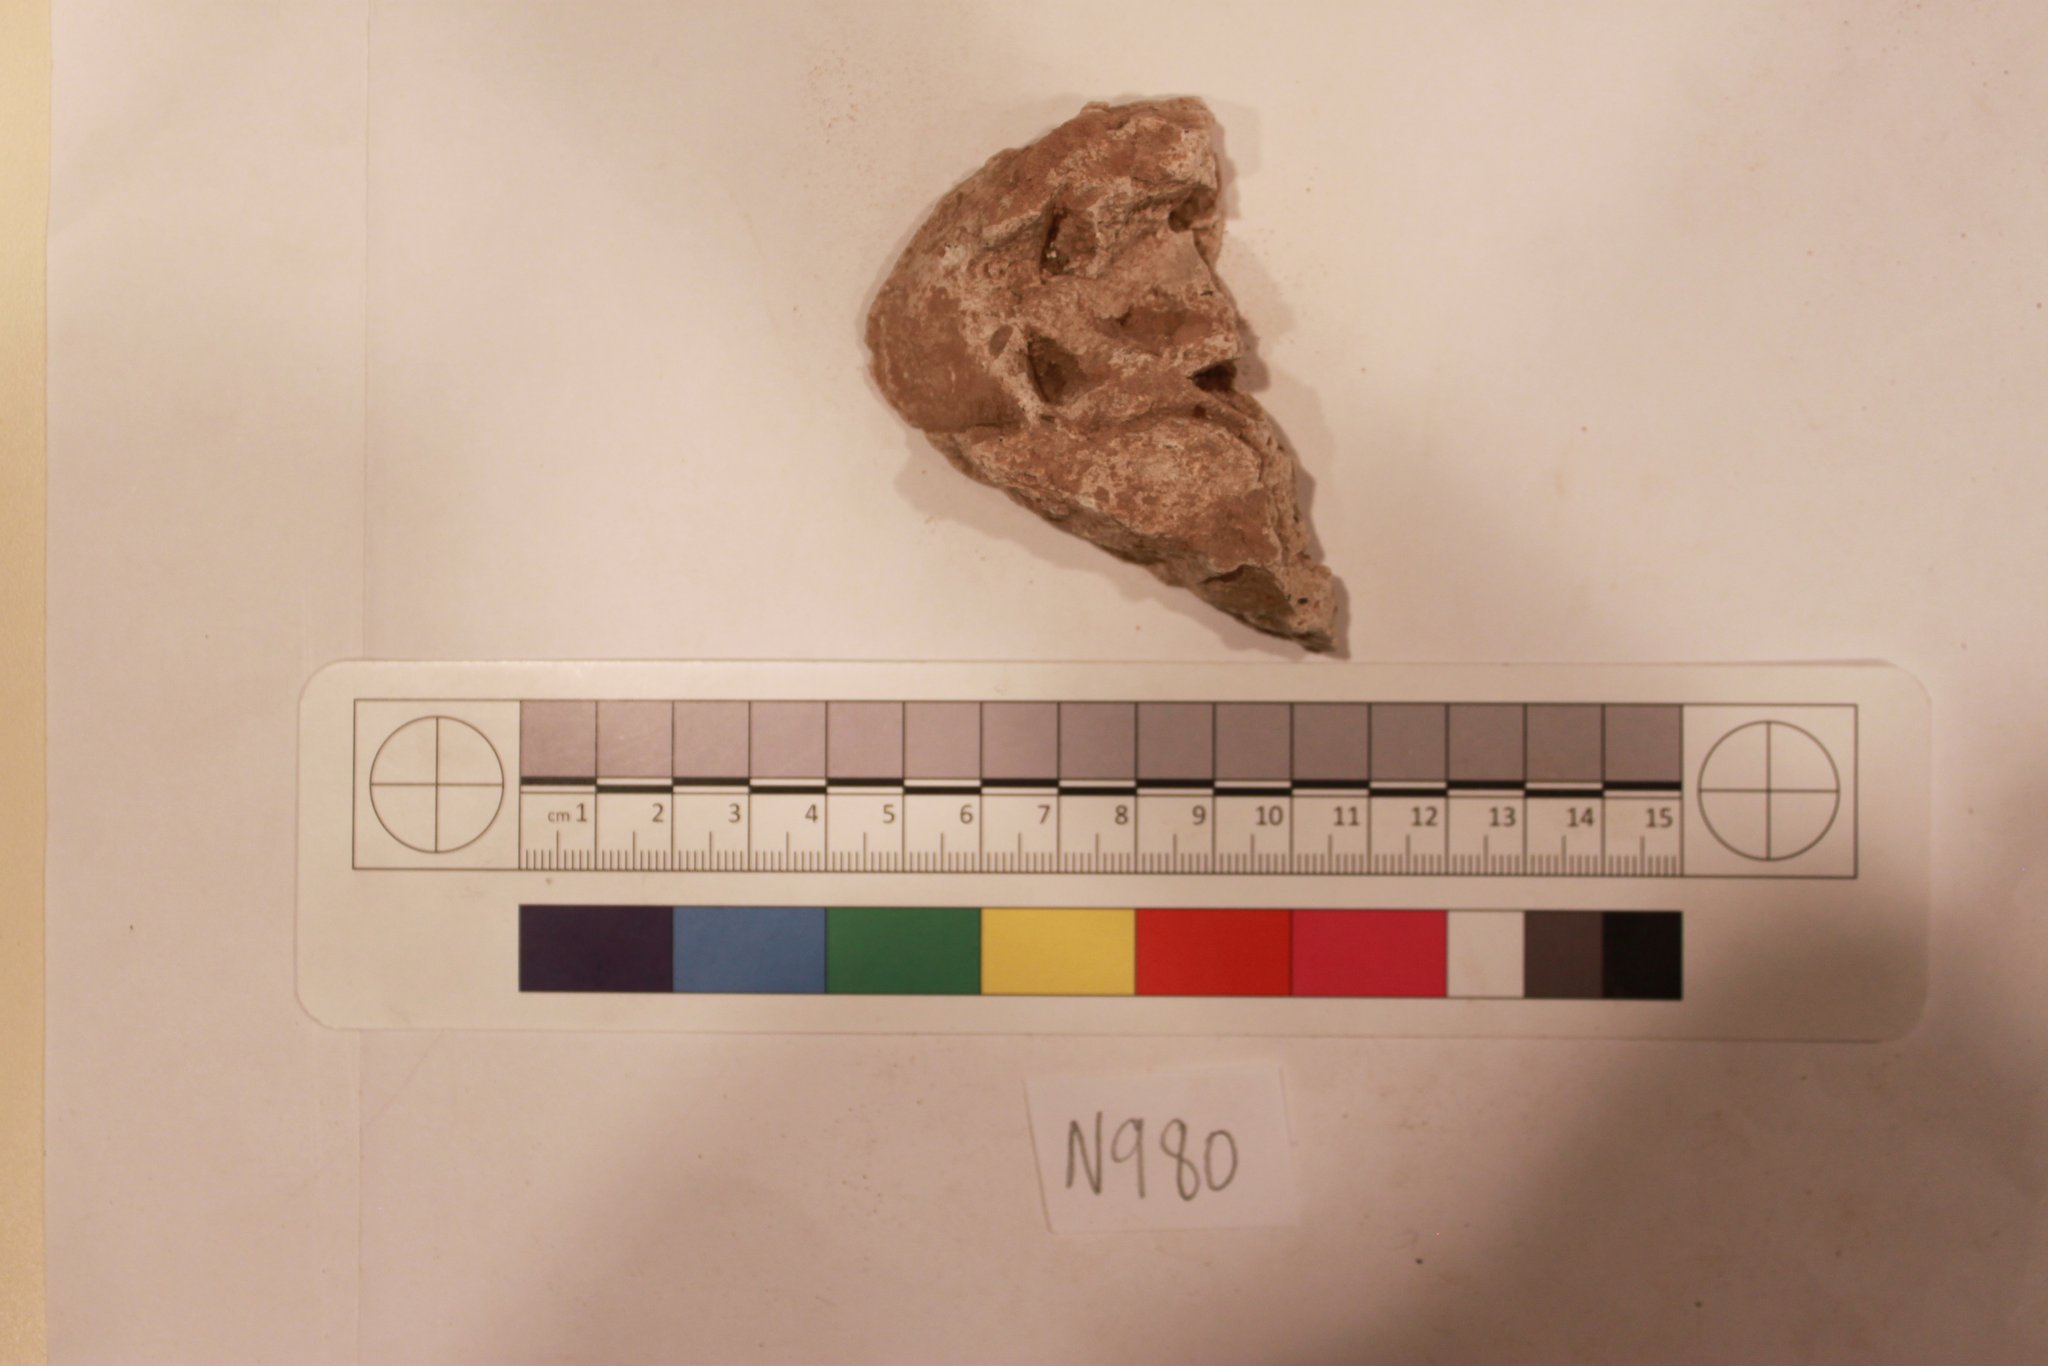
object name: fragment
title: Stucco Fragment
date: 701-1200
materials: plaster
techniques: carving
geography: iran